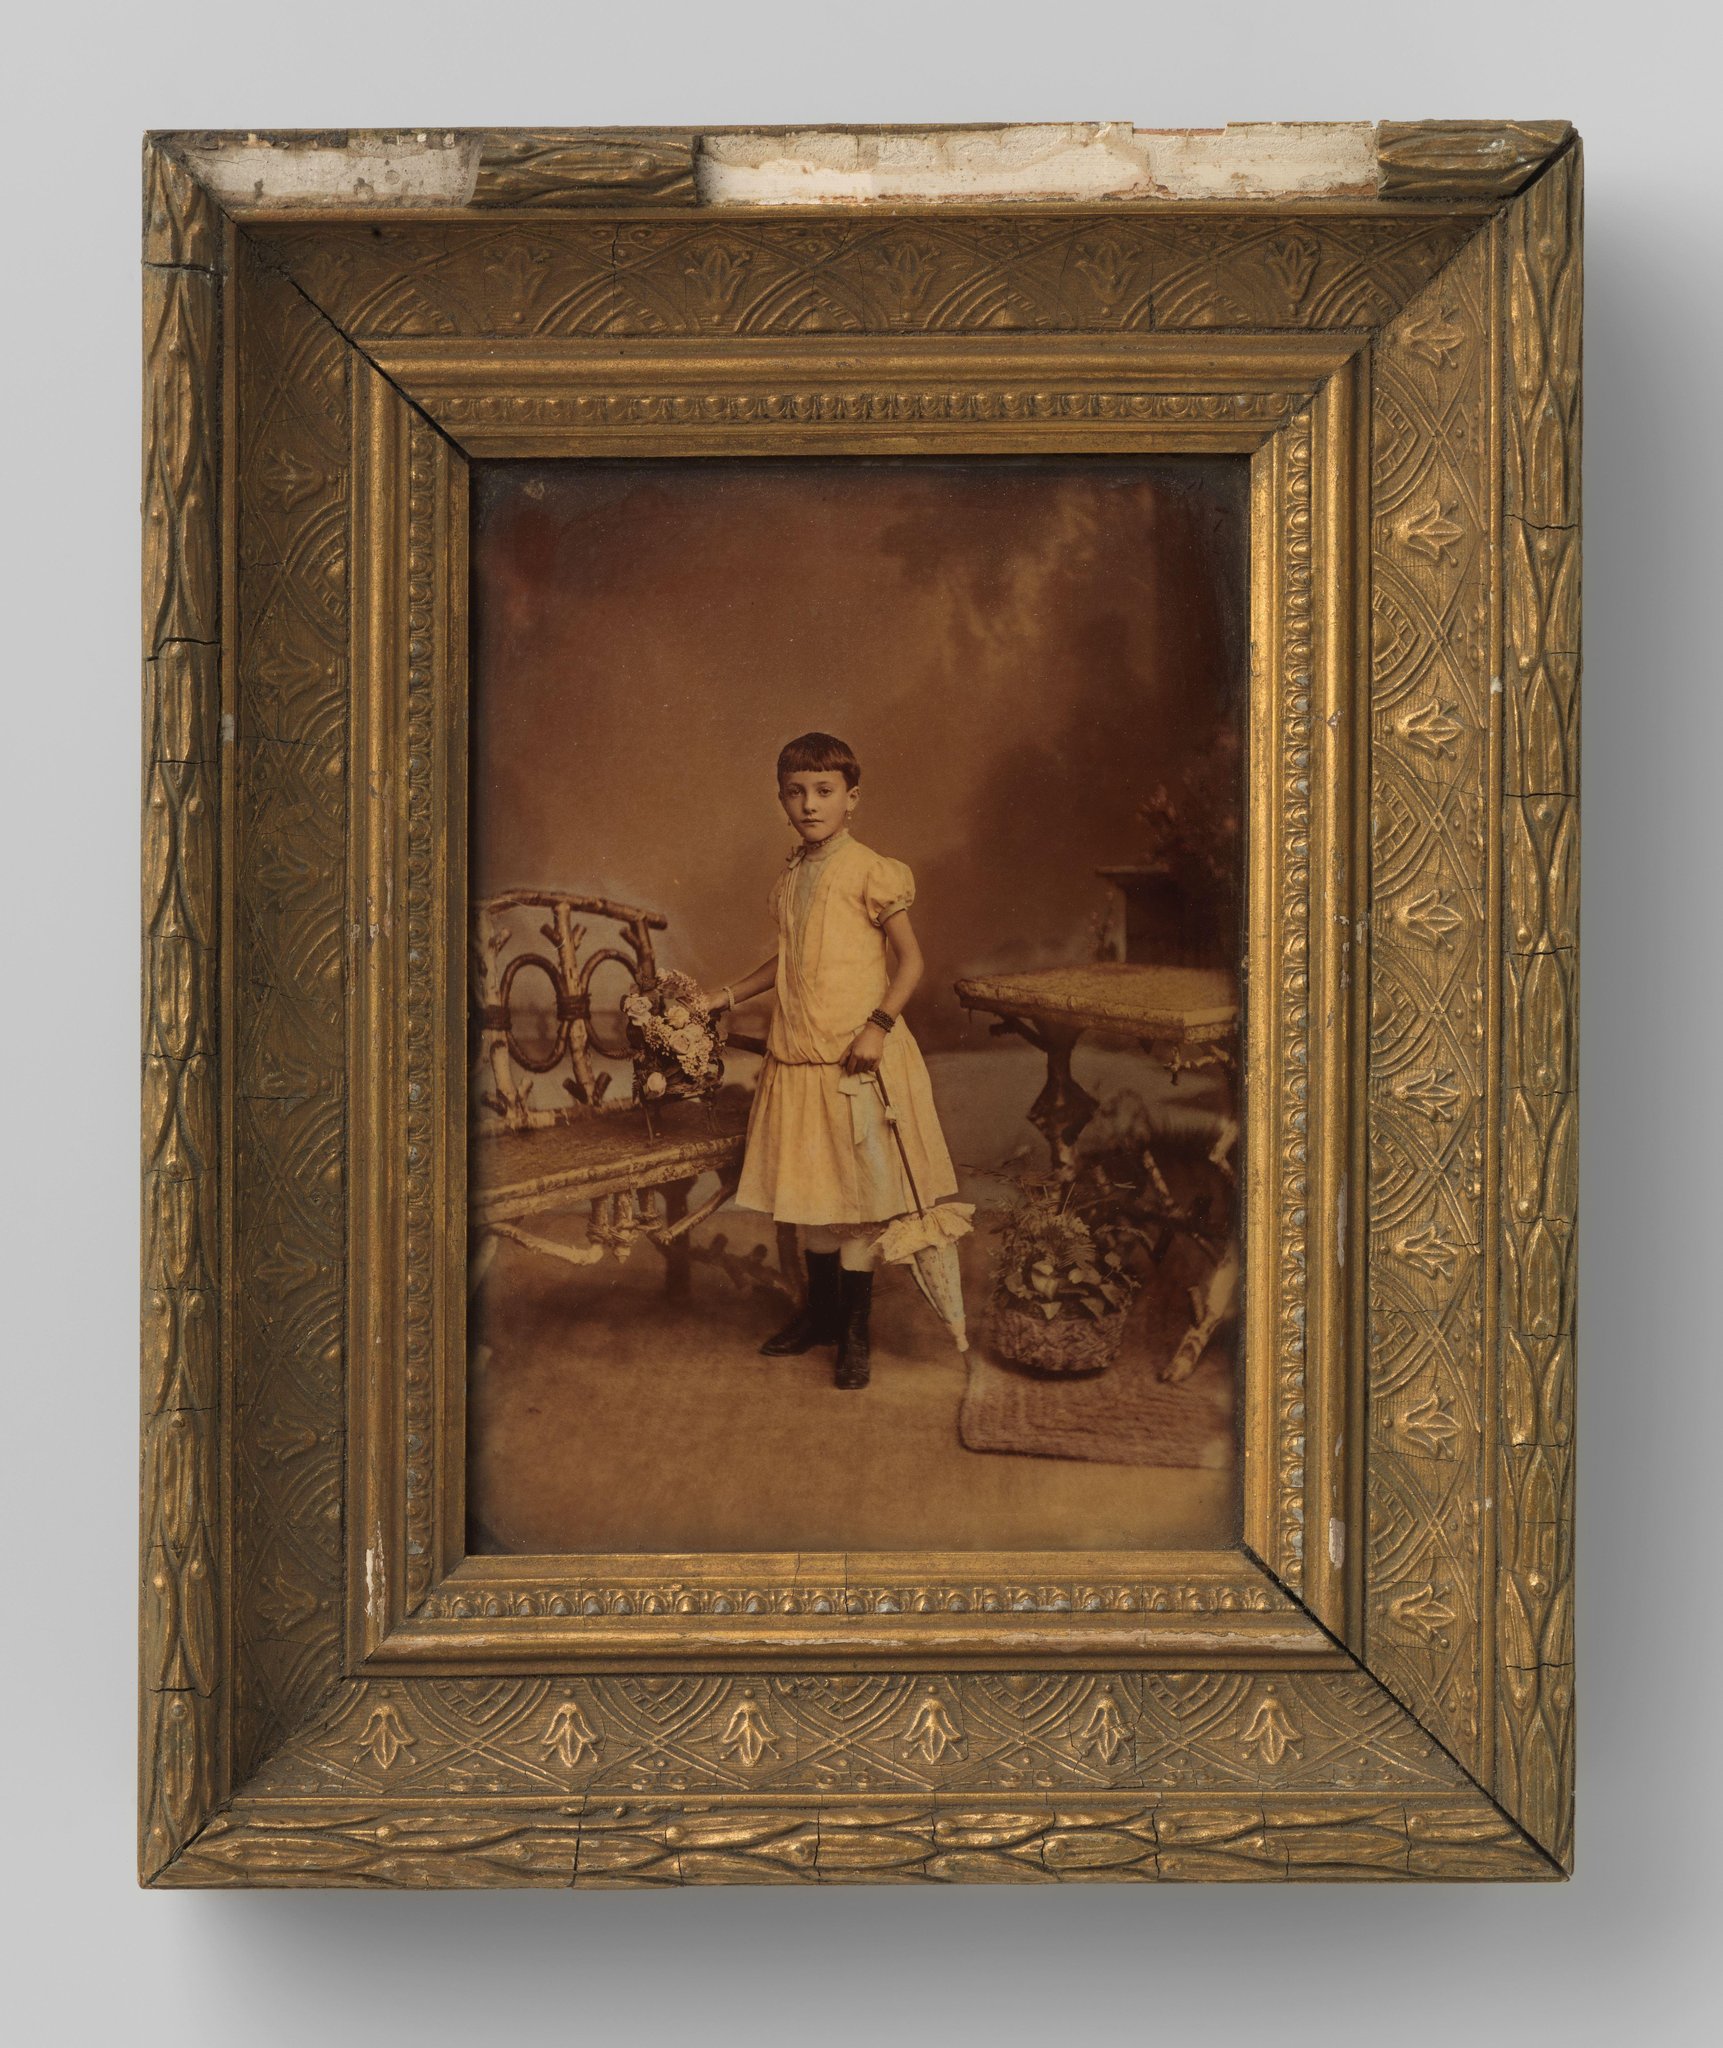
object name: photograph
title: Portret van een onbekend meisje, staande naast een houten bank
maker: Anonymous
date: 1880-1900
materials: cardboard, glass, metal, paper, fiber, wood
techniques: albumen print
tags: studio requisites ~ photographer, girl (child between toddler and youth), anonymous historical person portrayed